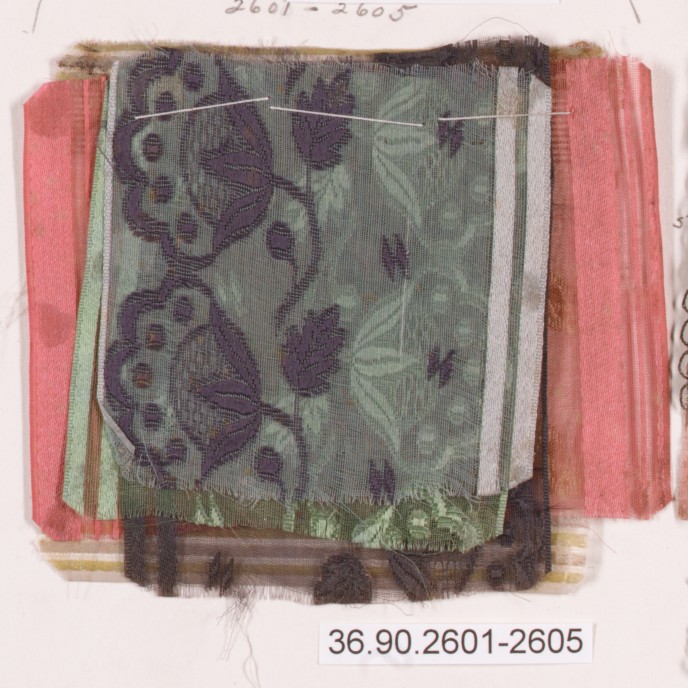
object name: ribbon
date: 1801-1900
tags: flowers